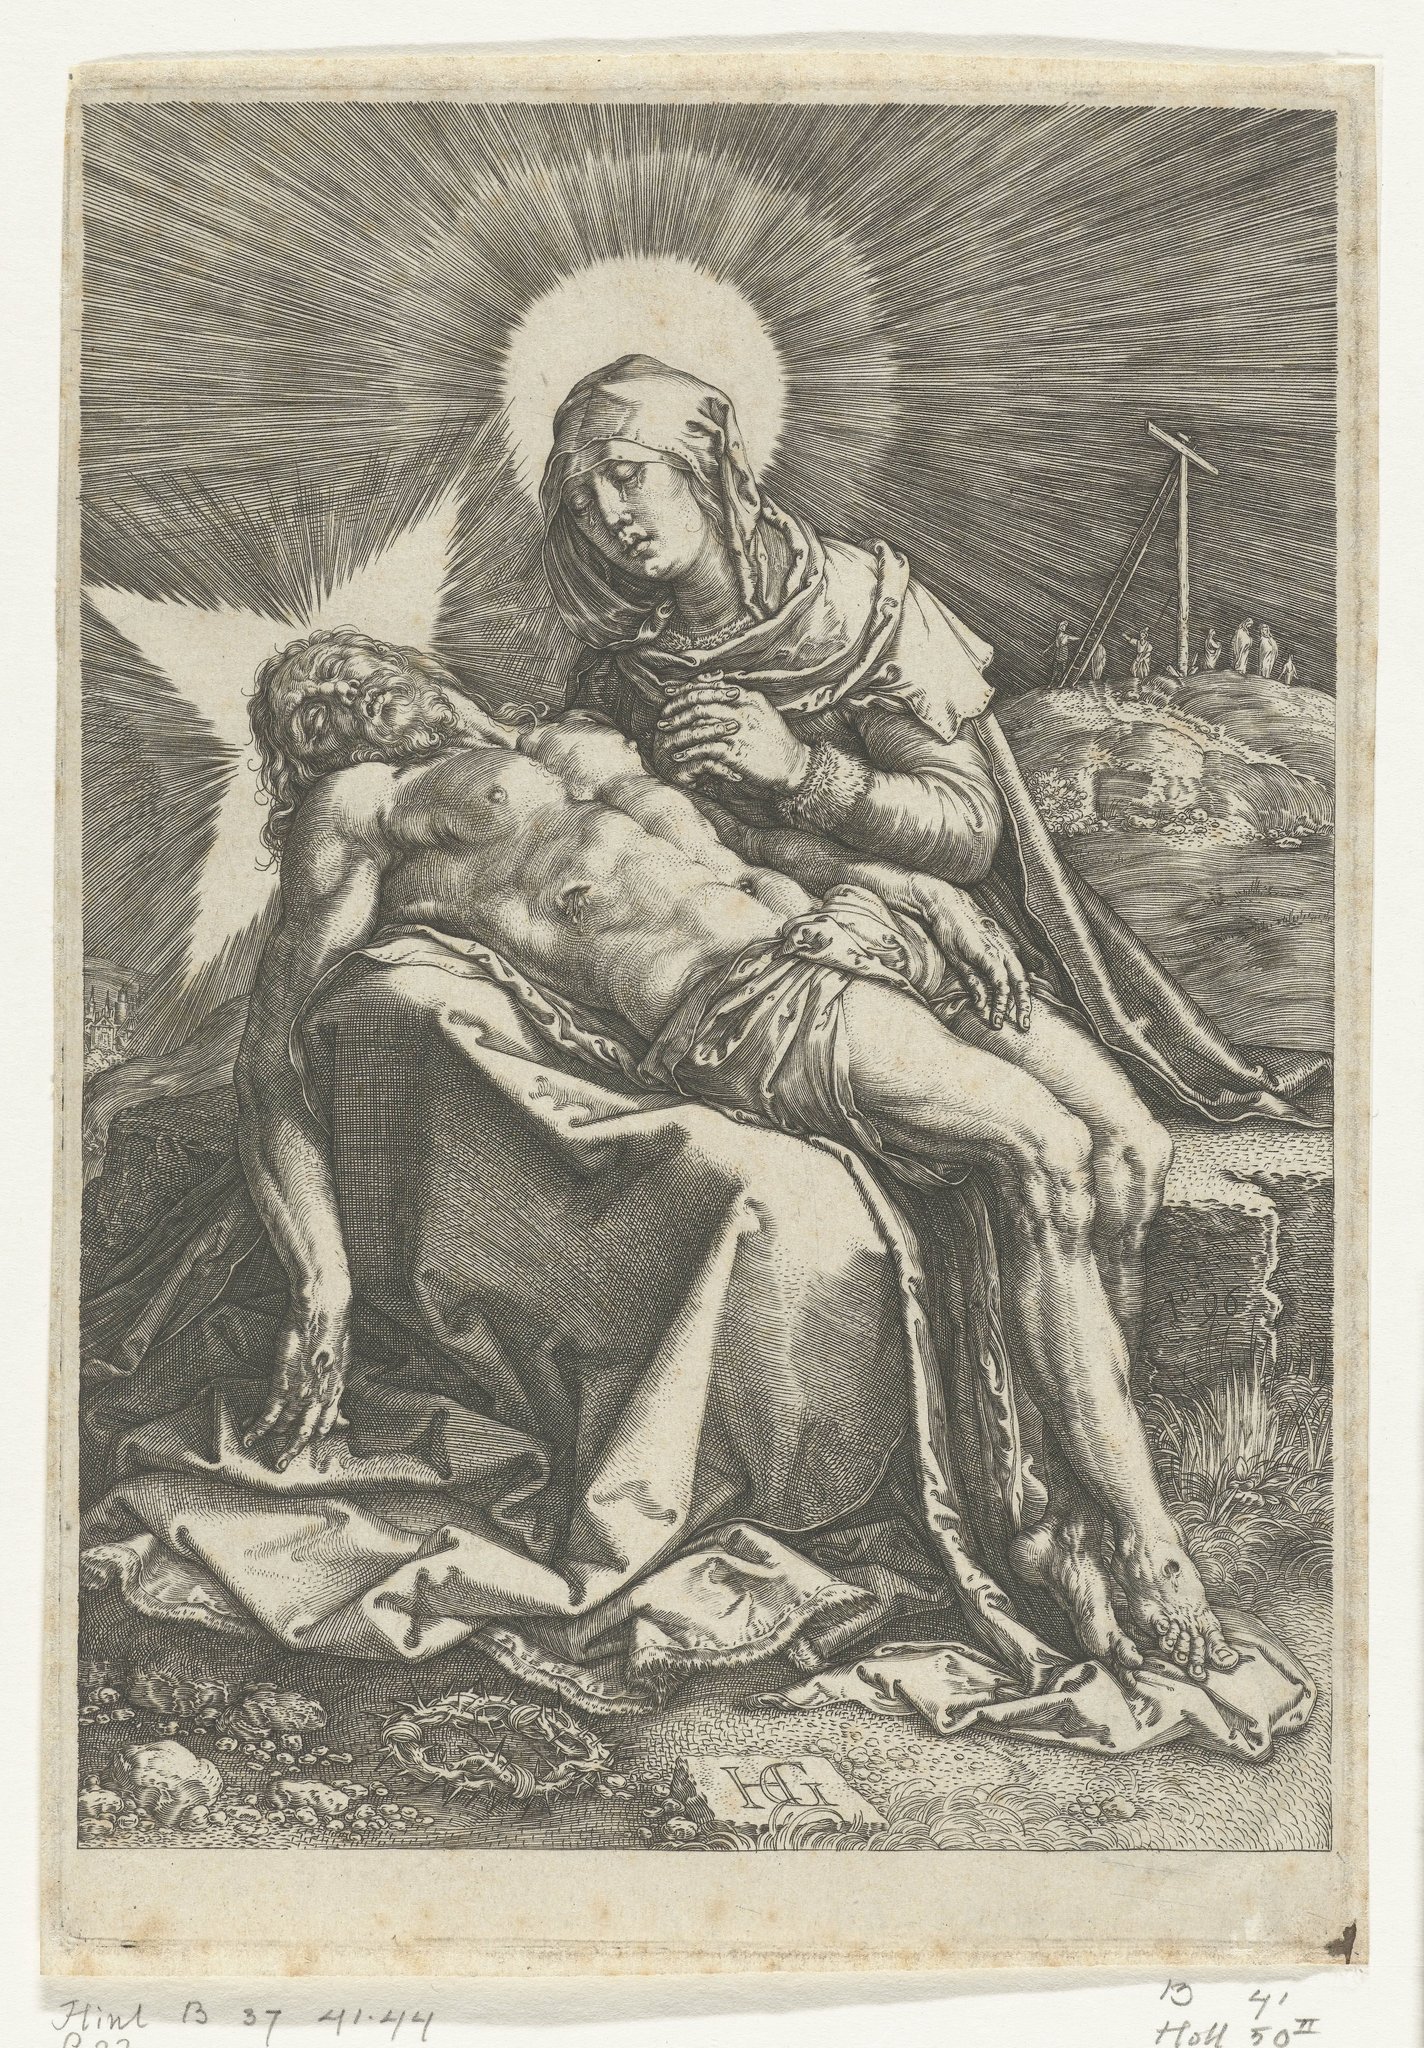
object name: print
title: Piëta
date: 1596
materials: paper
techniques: engraving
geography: haarlem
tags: 'pietà ', 'vesperbild', 'marienklage' (no others present): christ, either with or without crown of thorns, mourned by mary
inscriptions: monogram: ‘HG’, date: ‘Ao. 96’, collector's mark: Lugt 10, collector's mark: Lugt 11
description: Maria met de gestorven Christus in de armen, hem bewenend, zittend op een steen.